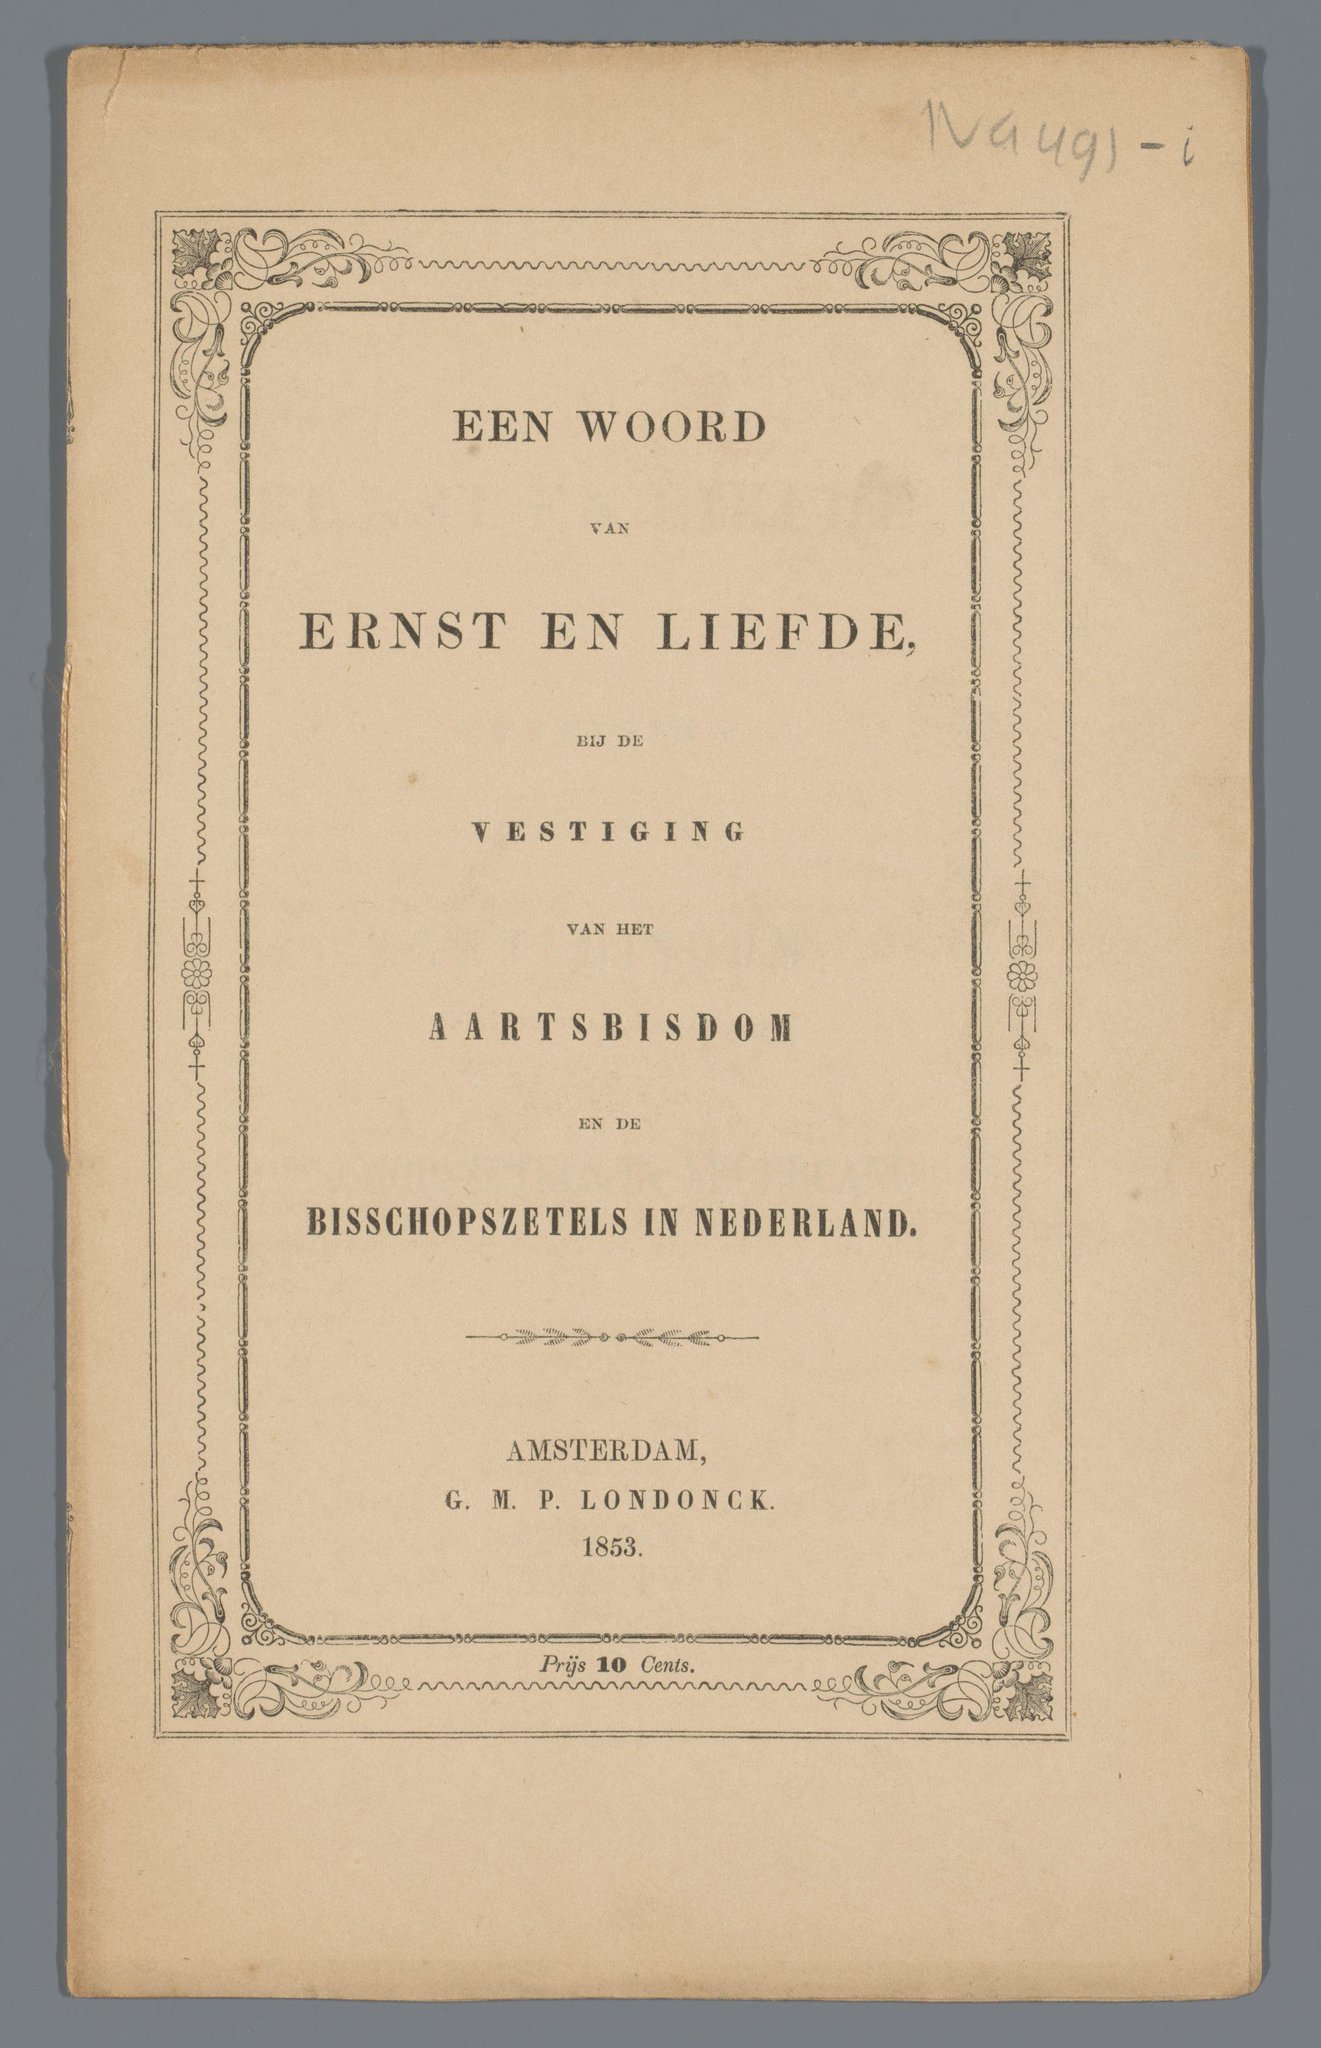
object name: brochure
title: Een woord van Ernst en Liefde, bij de vestiging van het Aartsbisdom en andere bisschopszetels in Nederland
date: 1853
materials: paper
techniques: brocade, printing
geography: amsterdam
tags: netherlands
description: Brochure van 16 genummerde pp, zonder omslag, van RK origine, gericht tot de protestanten.